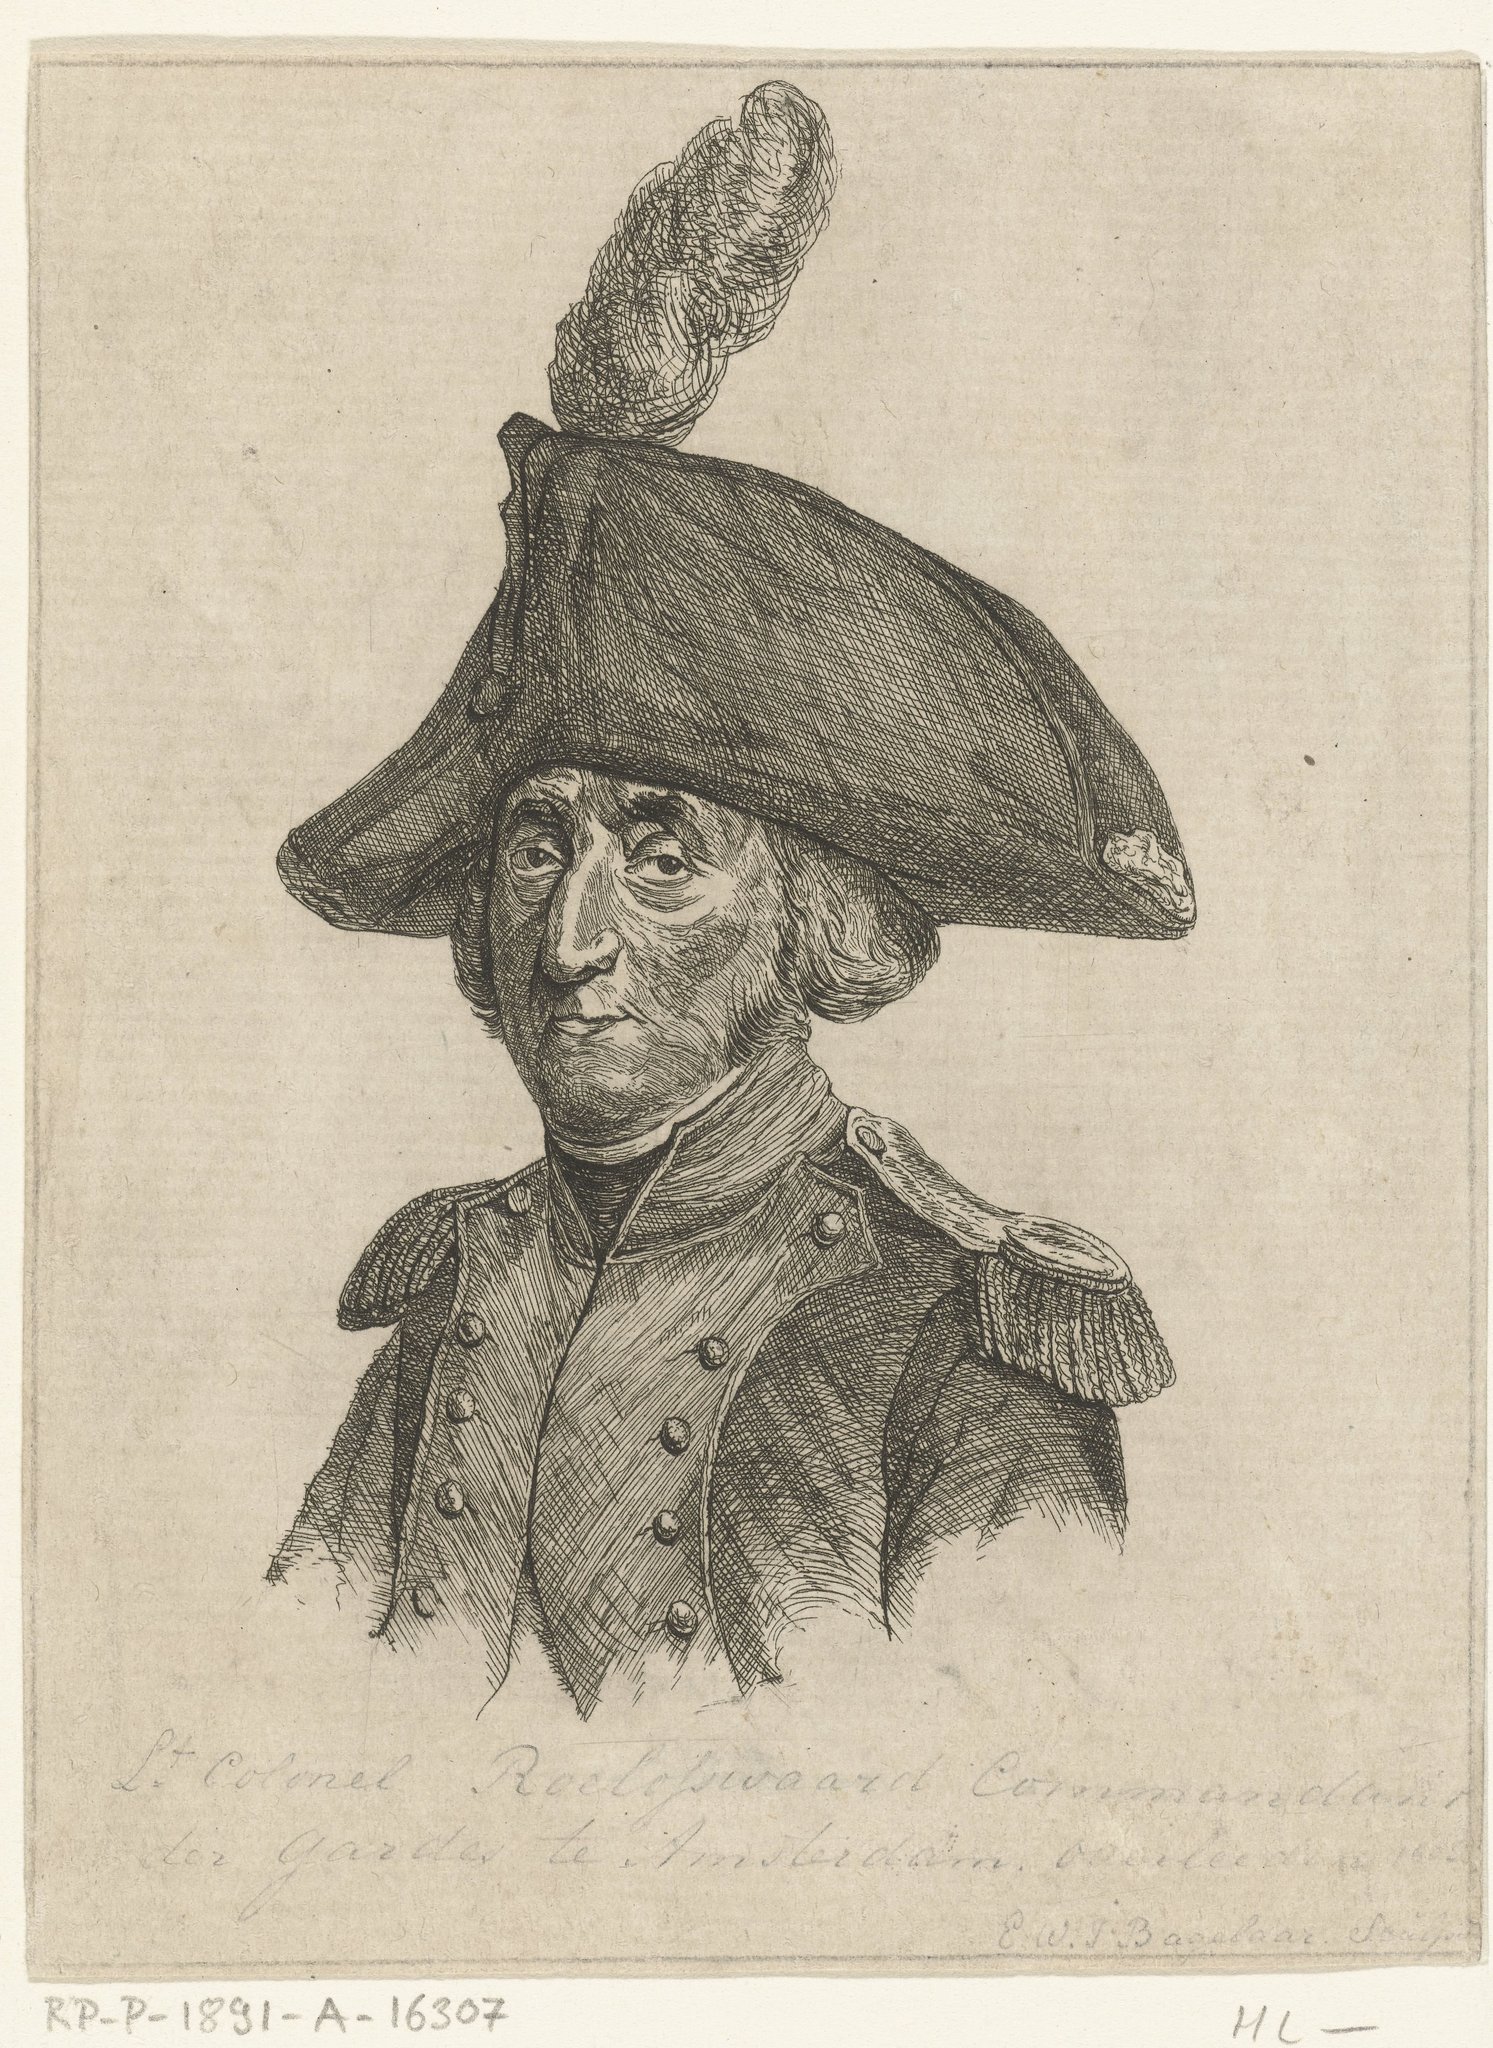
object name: print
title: Portret van luitenant-kolonel Benjamin Roelofswaard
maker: ernst willem jan bagelaar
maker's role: draughtsman, print maker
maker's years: 1775-1837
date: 1798-1837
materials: paper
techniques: etching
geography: netherlands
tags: kapitein, benjamin roelofswaard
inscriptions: collector's mark: Lugt 2228, inscription: ‘L. colonel Roelofswaard kommandant van de Gardes te Amsterdam J.W.I. Bagelaar inv e schulpsit’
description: Portretbuste naar links, met uniform en steek met opstaande pluim.